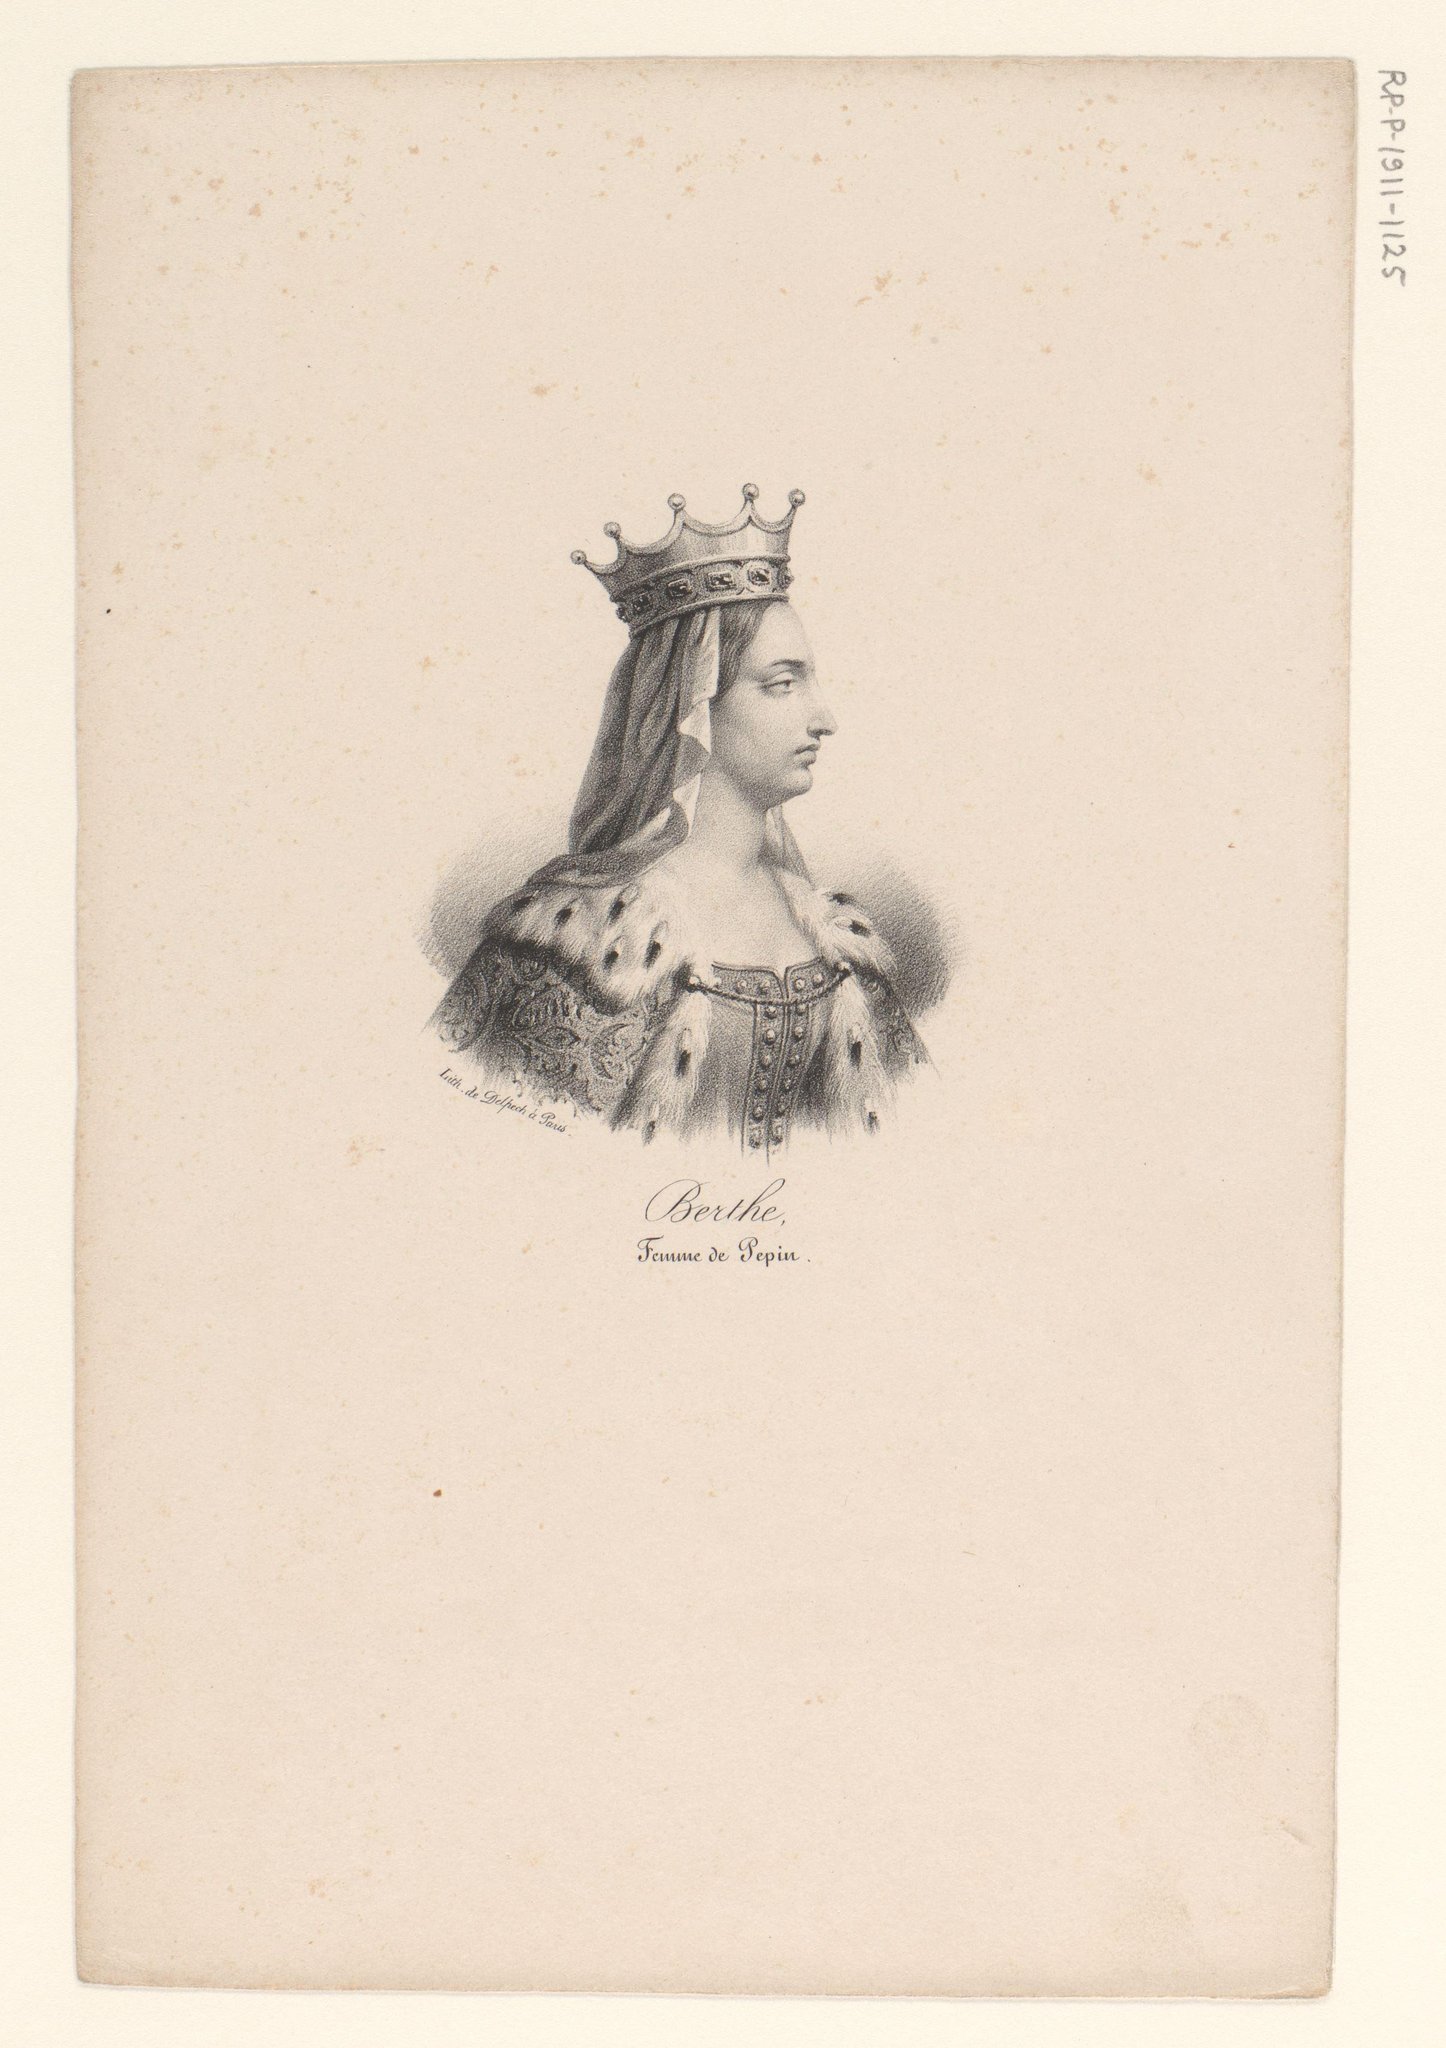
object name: print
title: Berthe, femme de Pepin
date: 1818-1842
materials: paper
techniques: lithograph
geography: paris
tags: historical persons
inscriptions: collector's mark: Lugt 2228a